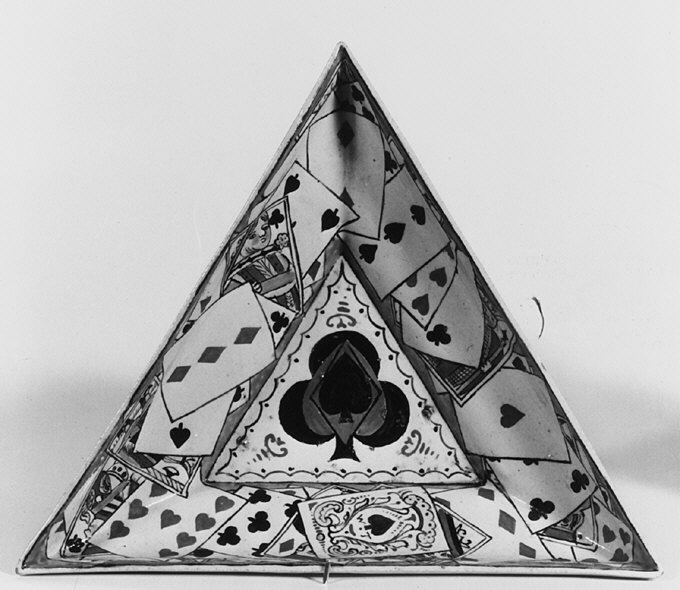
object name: sweetmeat dish or tray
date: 1760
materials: stoneware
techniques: salt glaze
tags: playing cards